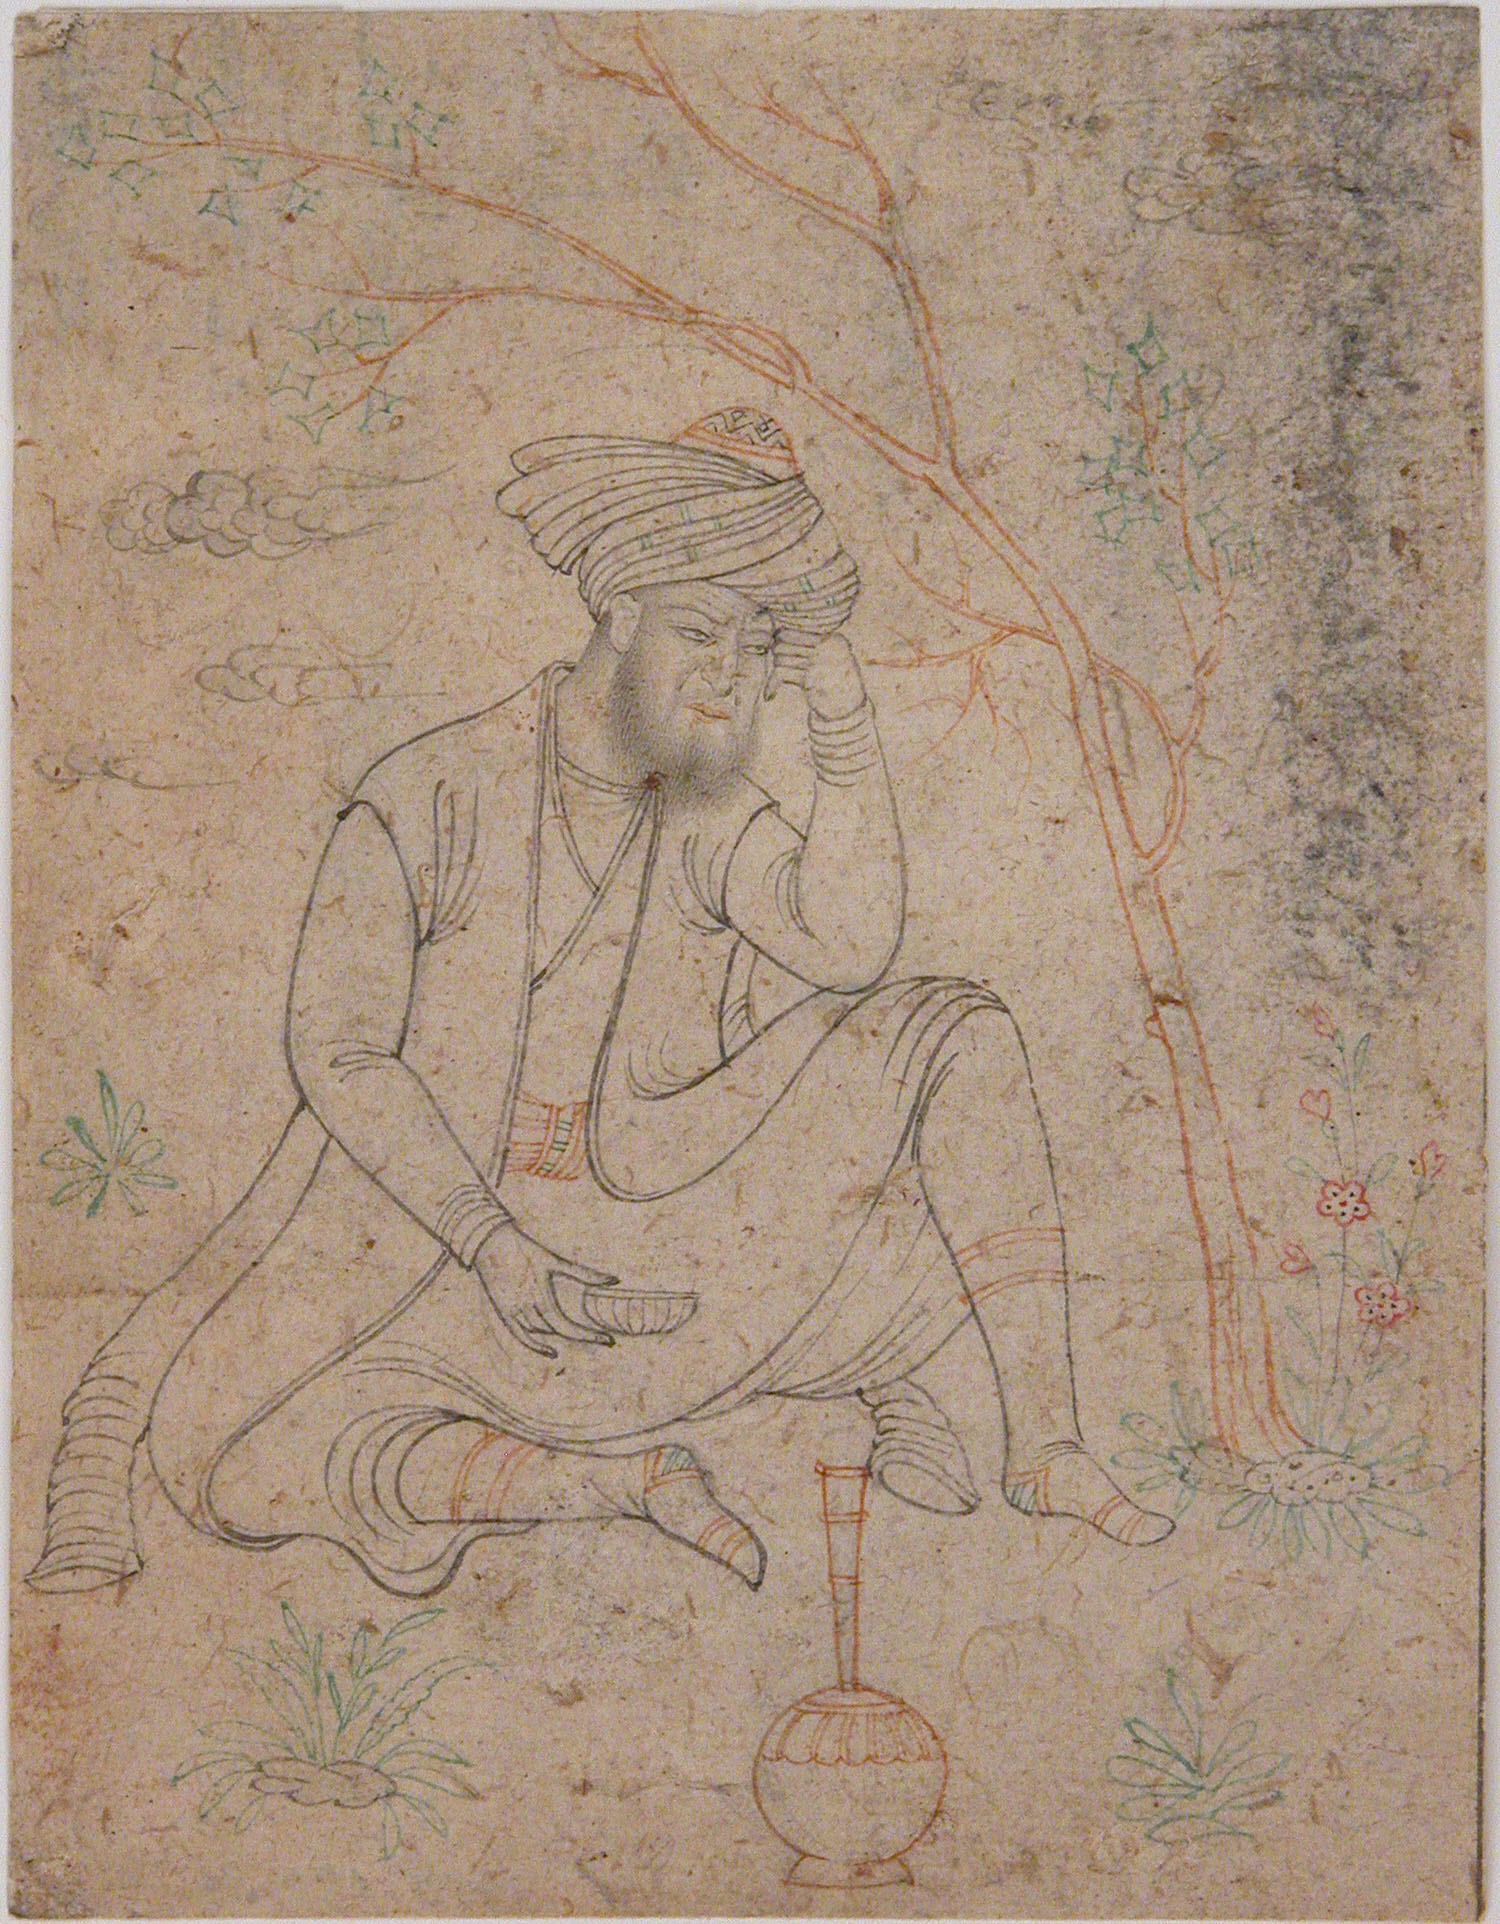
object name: illustrated single work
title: Bearded Man Holding a Cup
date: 1601-1633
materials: ink, paper, pencil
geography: iran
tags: men